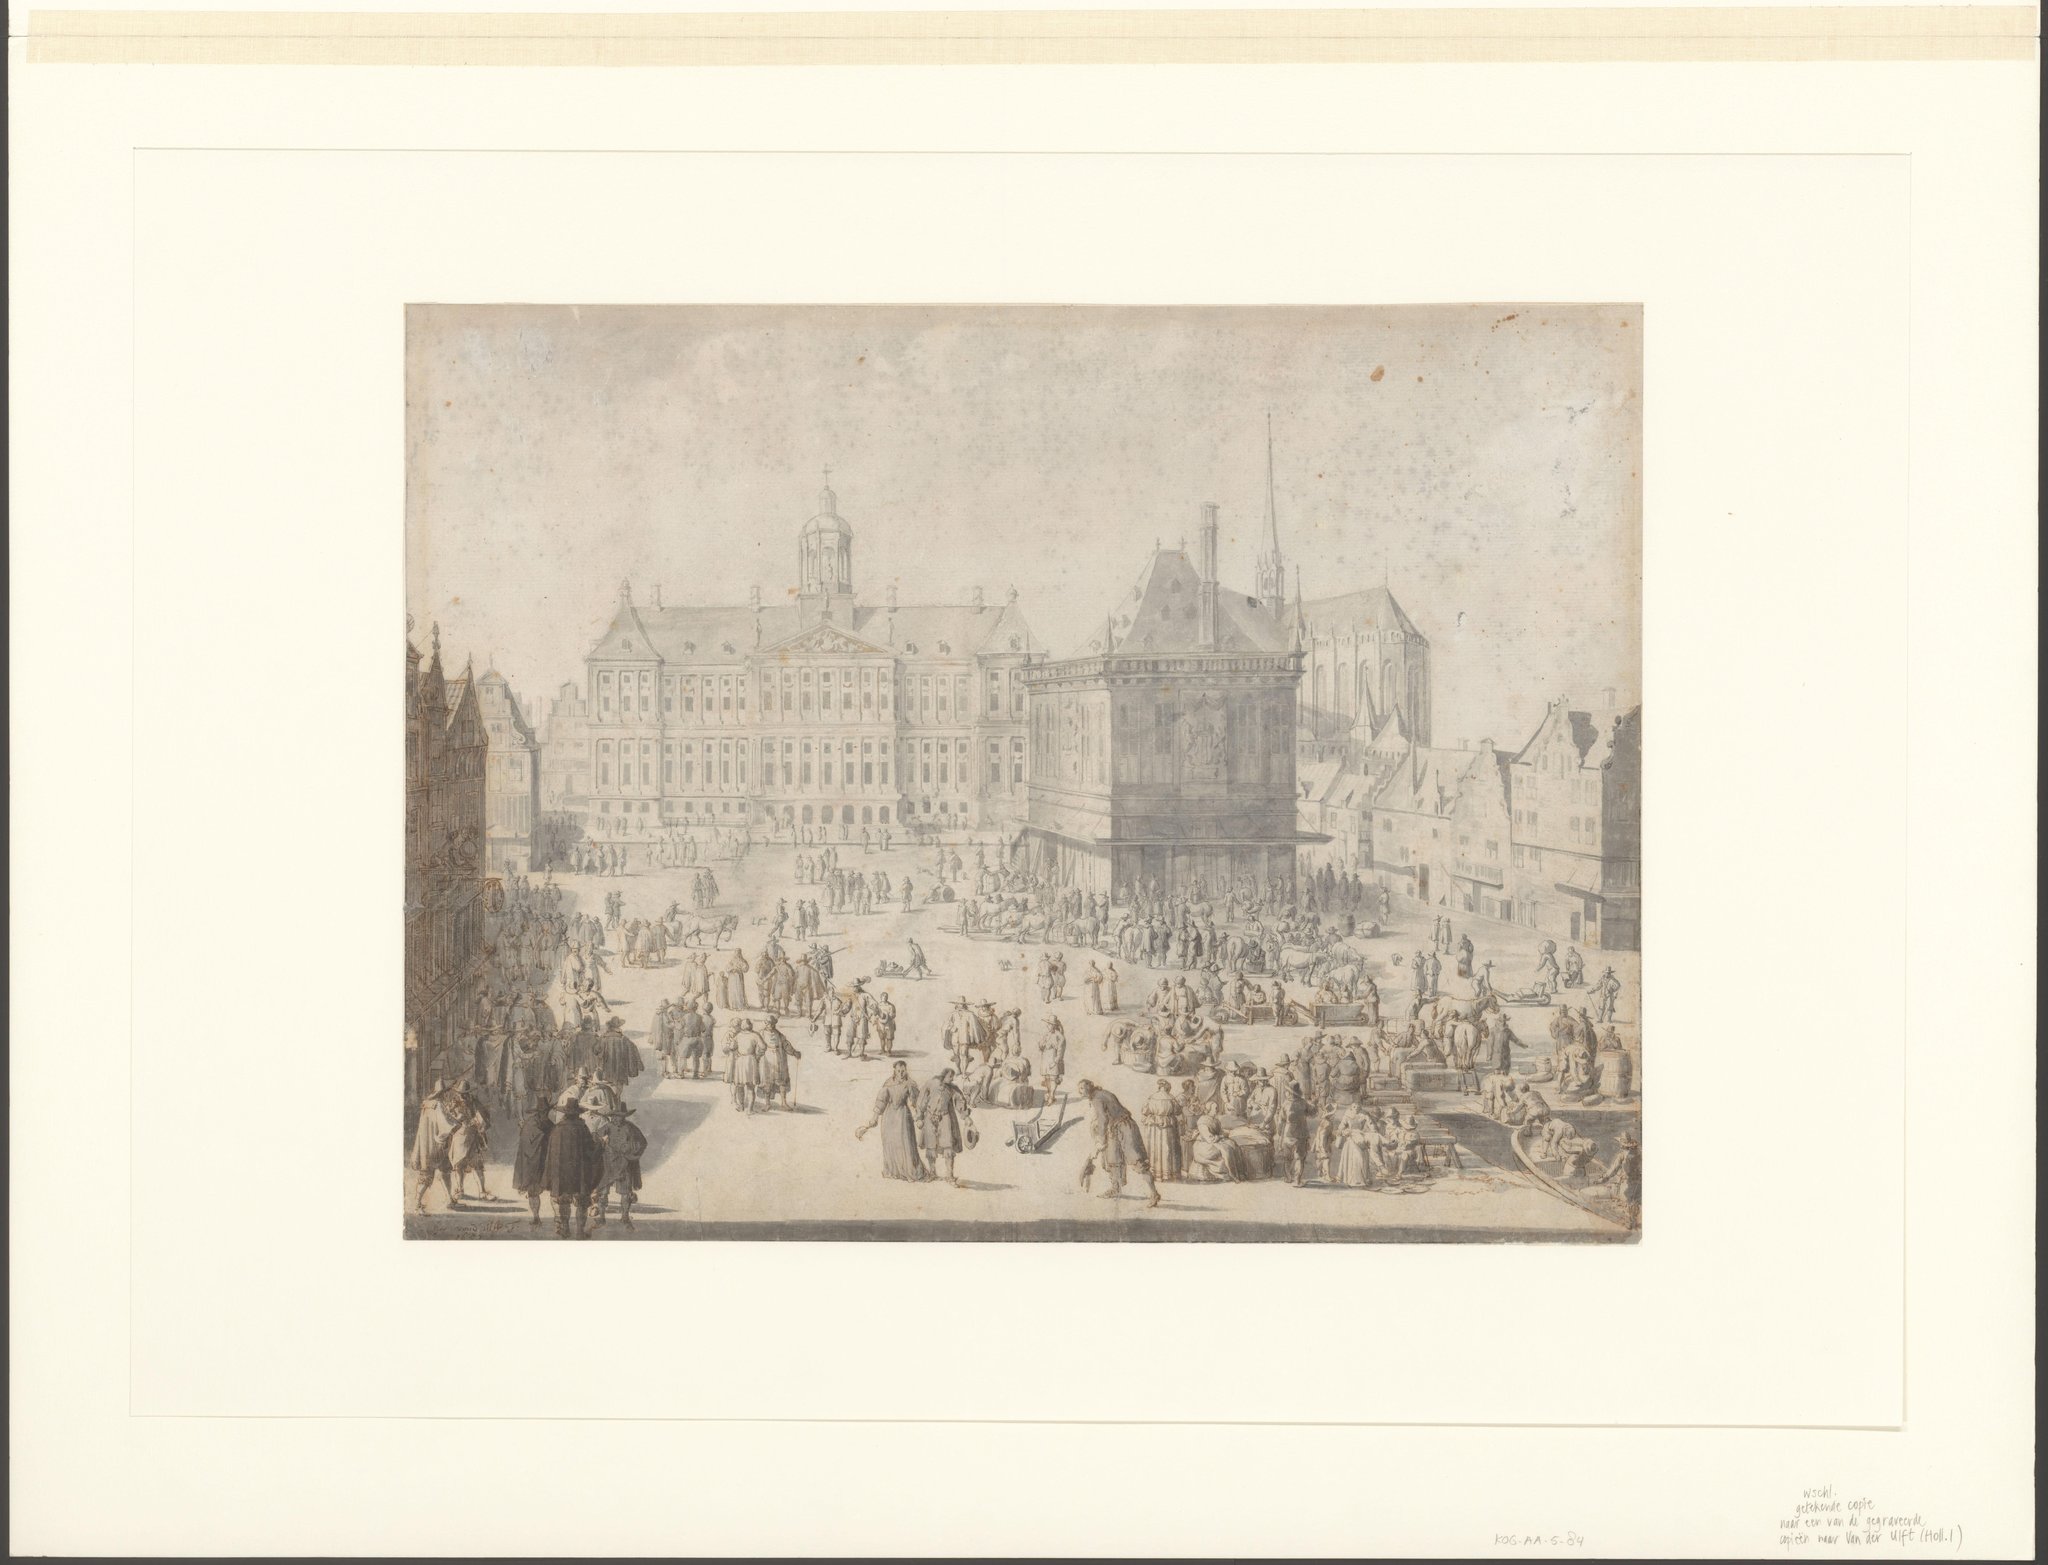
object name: drawing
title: Gezicht op het Stadhuis, de Waag en de Nieuwe Kerk op de Dam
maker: jacob van der ulft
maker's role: draughtsman, painter, print maker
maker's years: 1627-1689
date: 1653-1657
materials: ink, paper, pencil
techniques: brush, pen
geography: amsterdam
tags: square, place, circus, etc., city-view in general; 'veduta', church (exterior), townhall, weigh-house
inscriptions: number: ‘3’, signature and date: ‘Jac: vand Ulft F. / 165[...]’